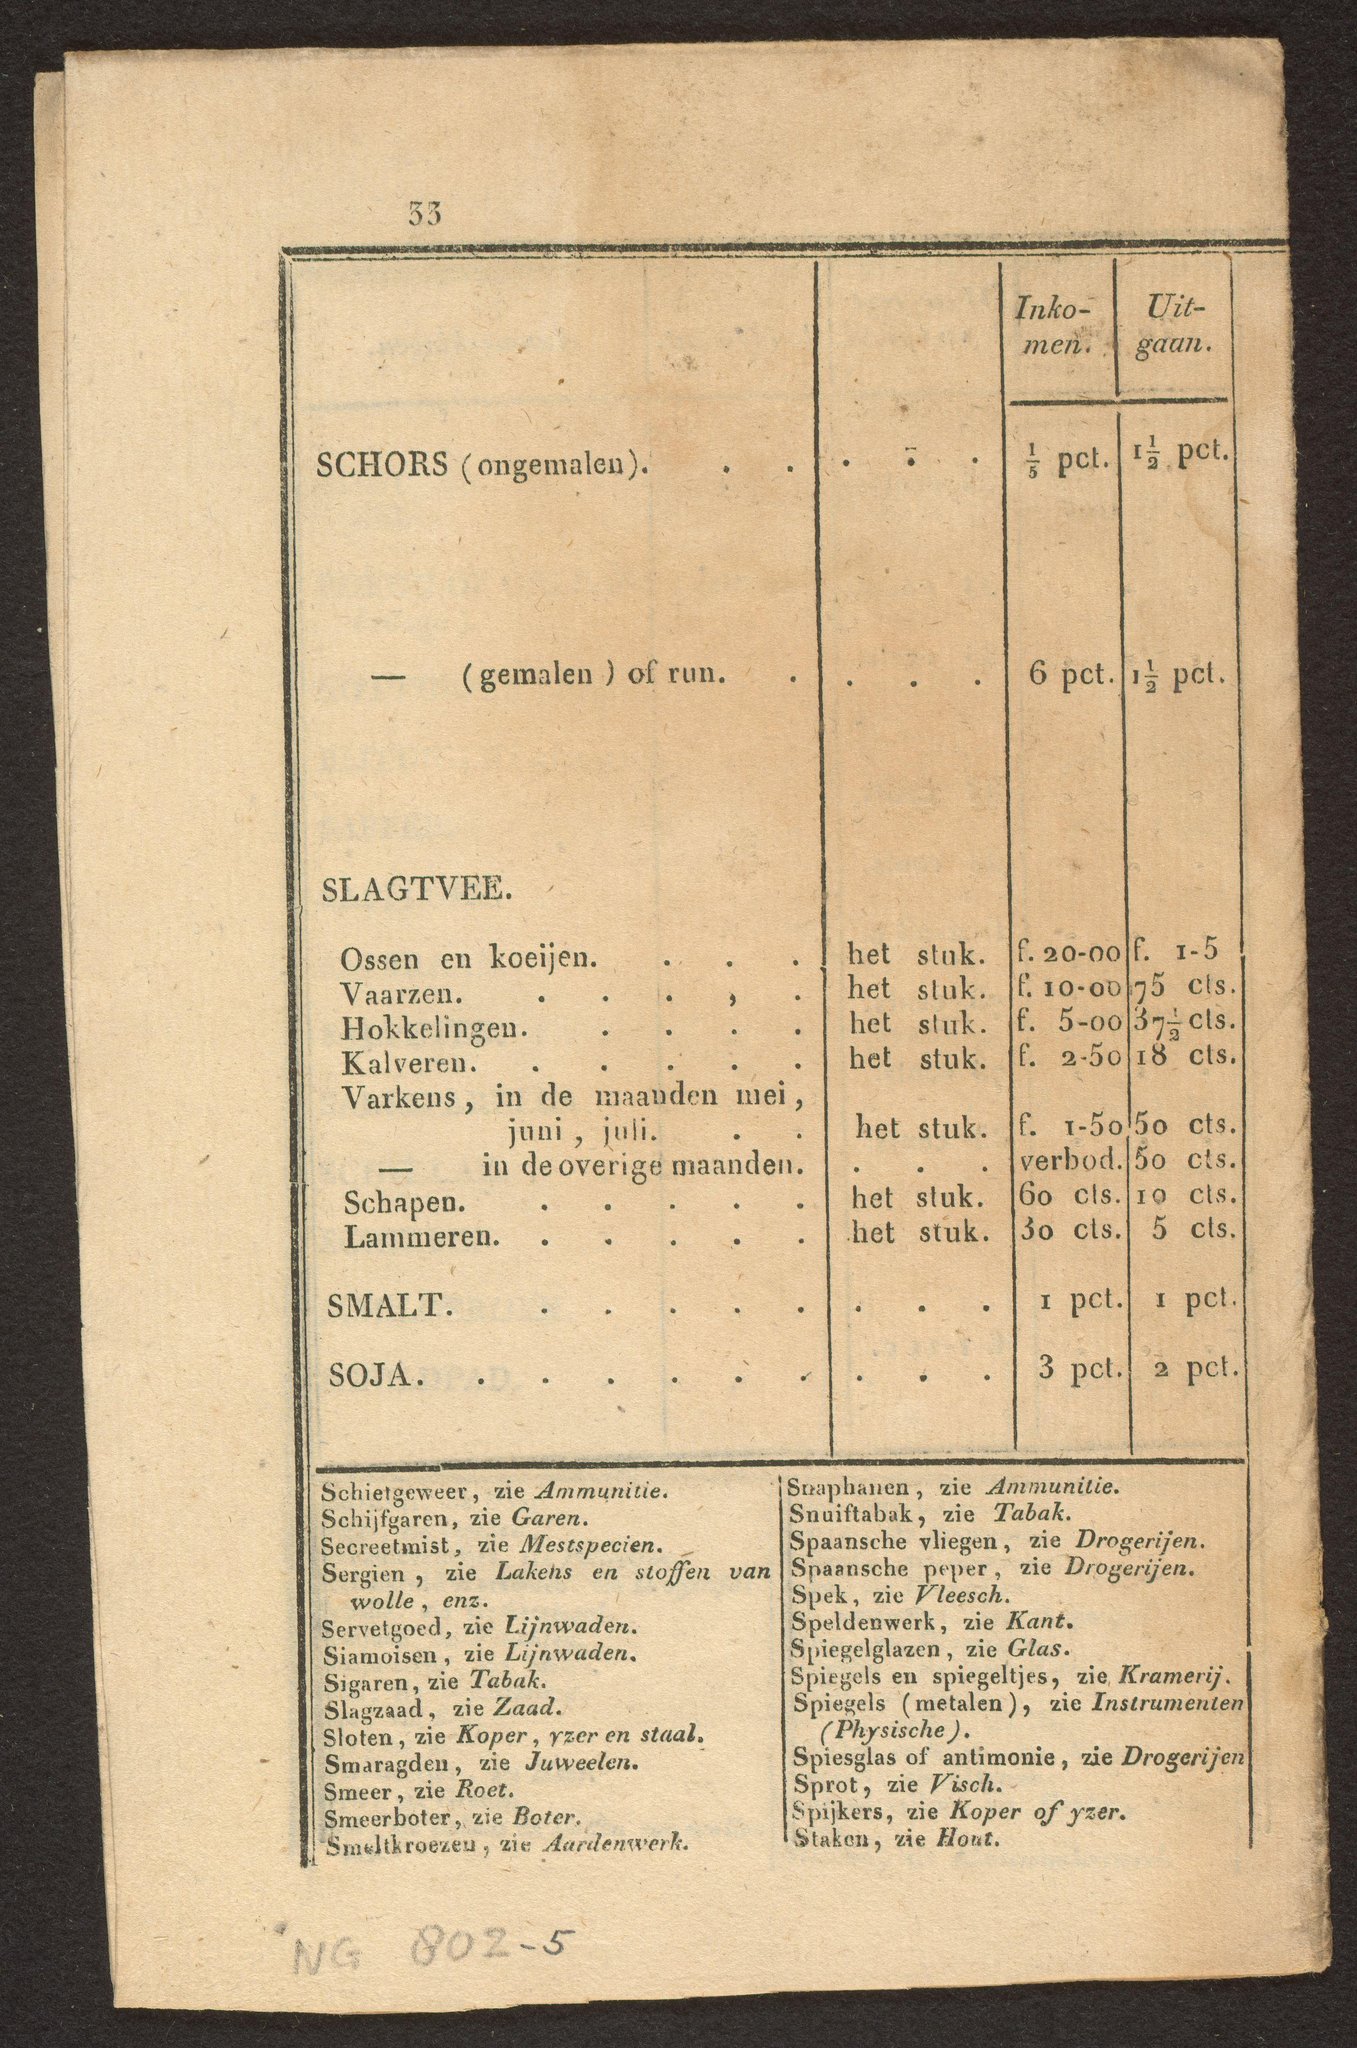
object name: brochure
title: Lijst of tarief van inkomende en uitgaande regten op alle goederen en koopmanschappen welke het koningrijk der Nederlanden zullen worden in- of uitgevoerd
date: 1819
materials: paper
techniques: folding, printing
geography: netherlands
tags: netherlands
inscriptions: date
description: Katern van een losbladige brochure, lijst met kolommen waarin gegevens over diverse handelswaar. Gedateerd en gemerkt.